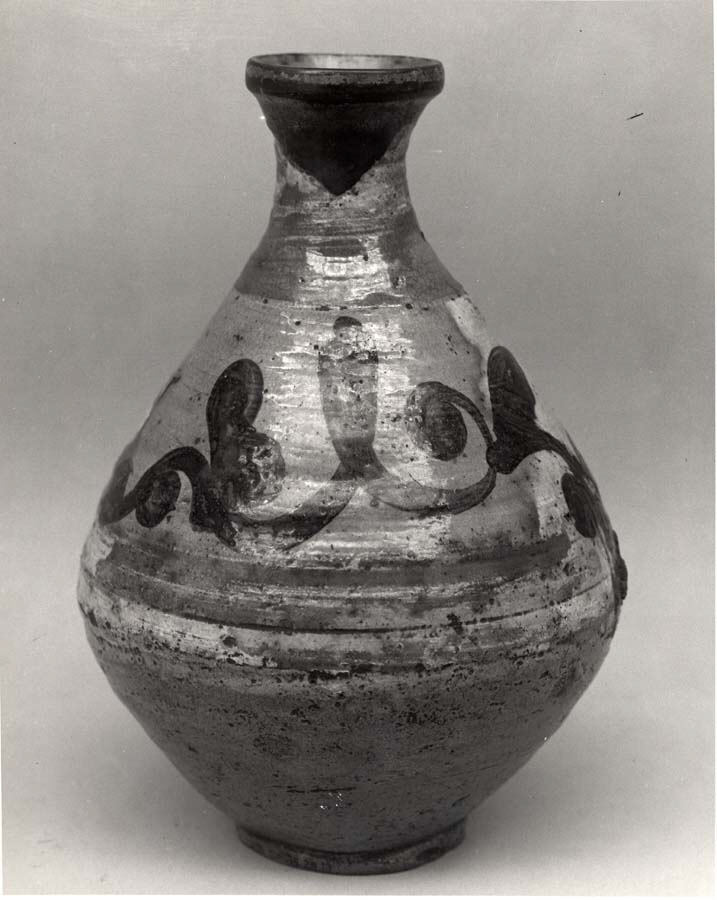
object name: vase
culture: korean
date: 1901-1933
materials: clay